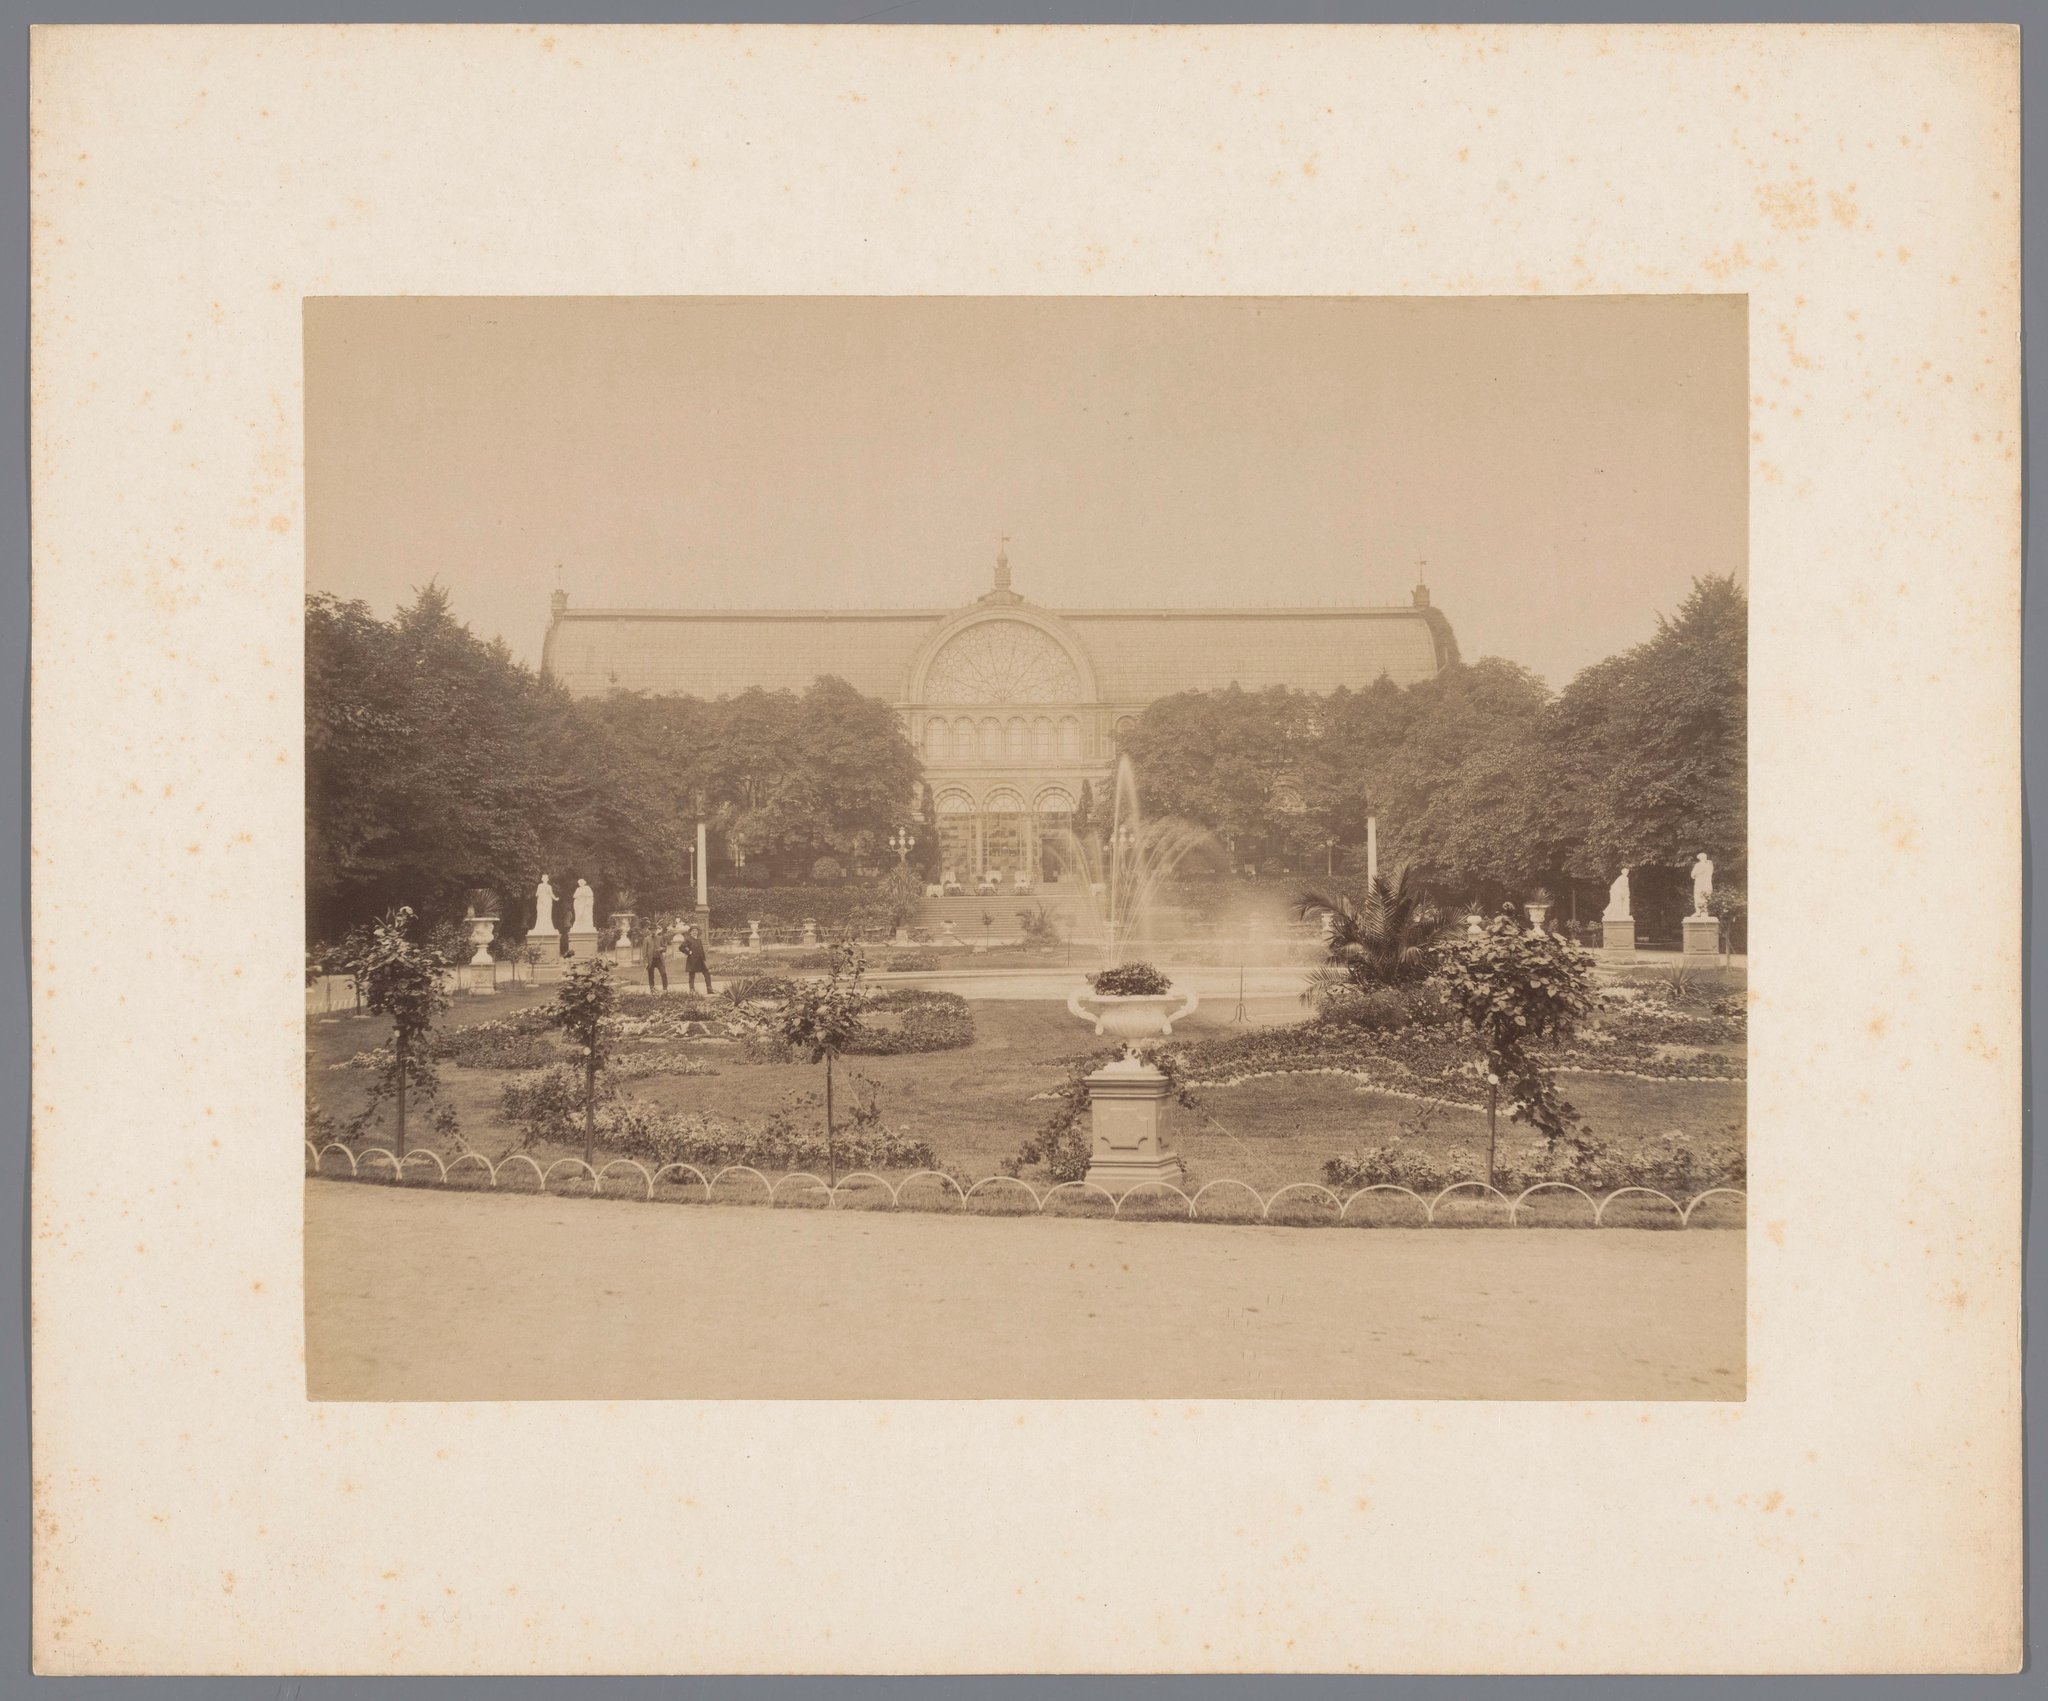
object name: photograph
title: Botanische tuin van de Flora te Keulen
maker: Anonymous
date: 1883-1900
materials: cardboard, paper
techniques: albumen print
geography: cologne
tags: botanic garden, 'hortus botanicus', cologne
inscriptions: inscription: ‘11 Zaterdag 27 Juni/ Cölner Flora/ 11’